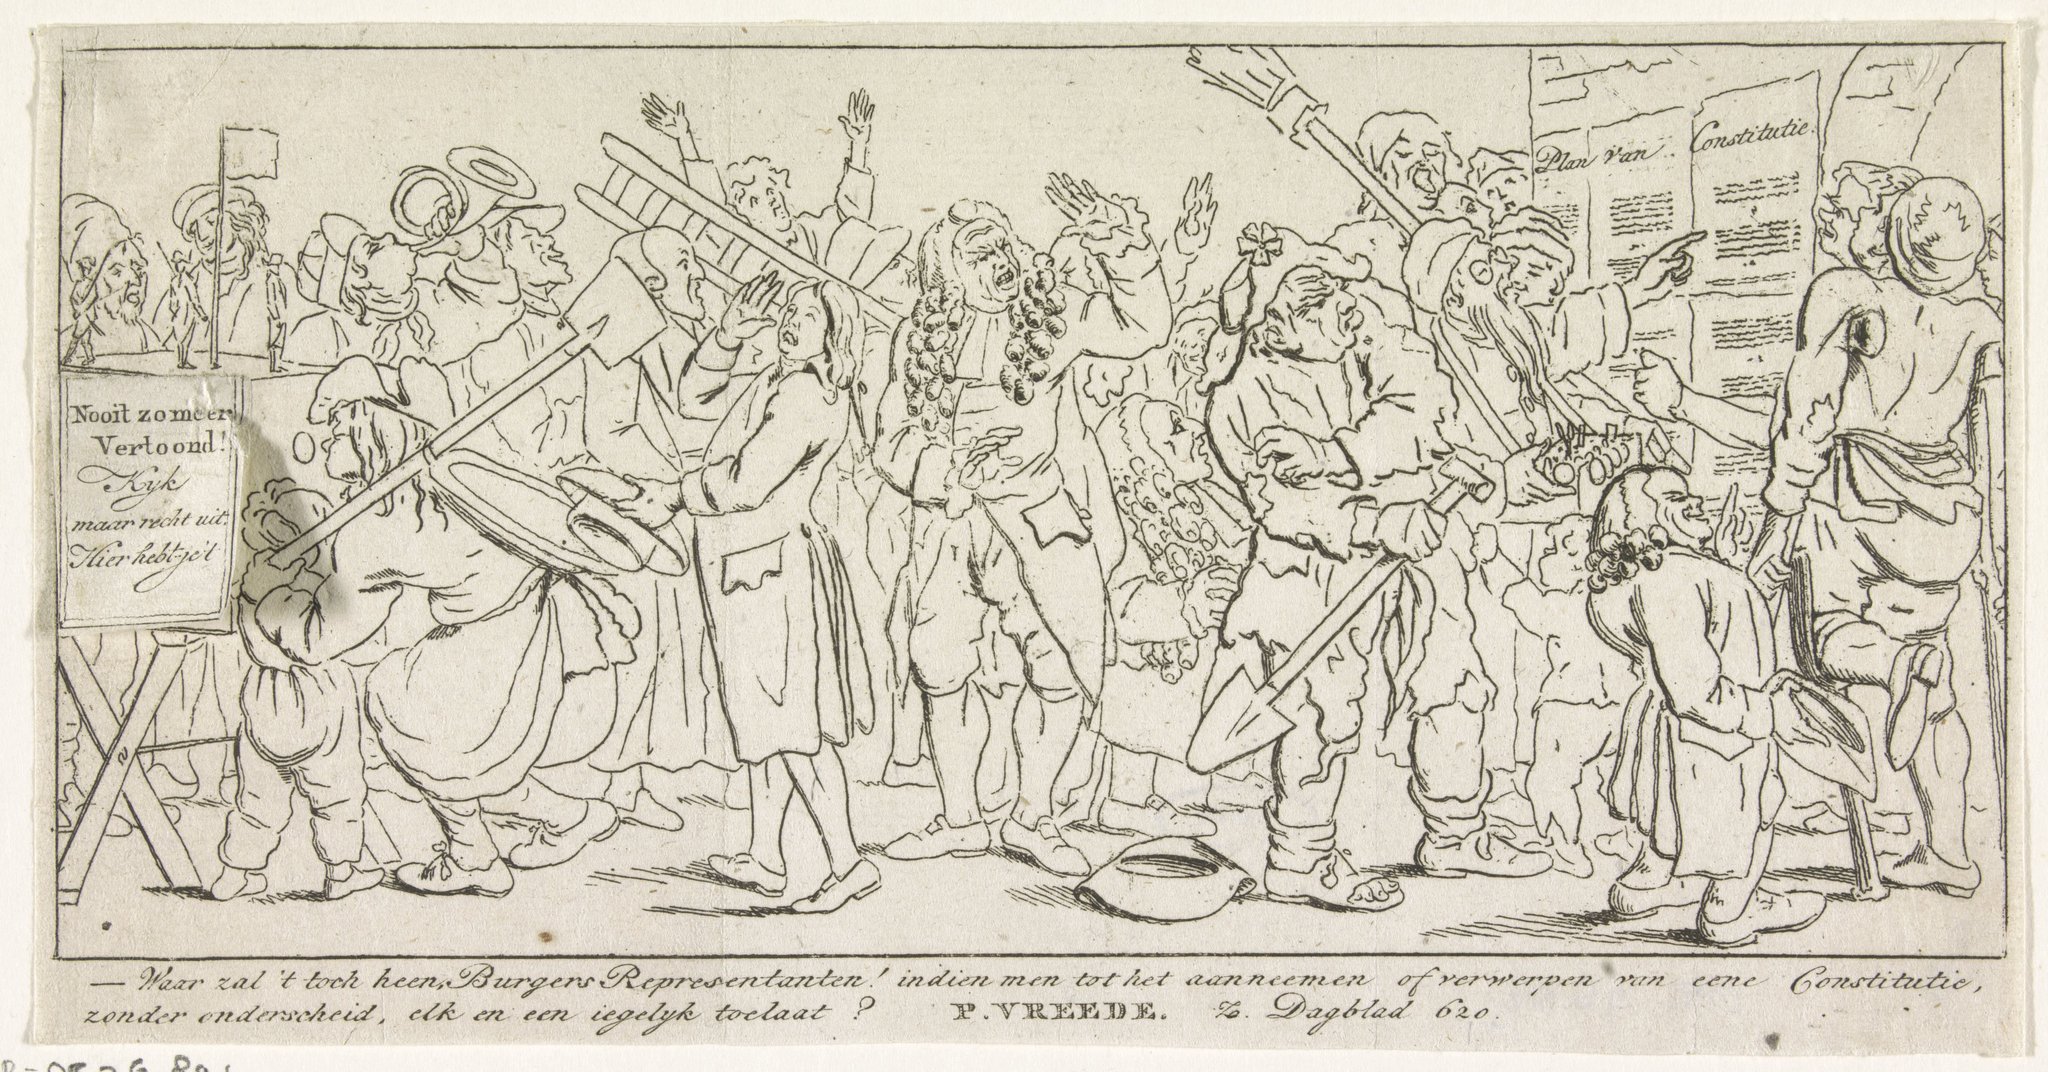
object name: print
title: Spotprent op verwerping van het Plan van Constitutie, 1797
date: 1797-1798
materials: paper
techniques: etching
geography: netherlands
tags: other kinds of amusement, political caricatures and satires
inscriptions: collector's mark: Lugt 2228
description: Spotprent waarin het volk het verwerpen van het Plan van Constitutie op 8 augustus 1797 bespot. Op een muur is het Plan geplakt dat gelezen en beoordeeld wordt het gewone volk en de burgerij. Links een kijkdoos waarbij een flap papier dat opgetild kan worden en waaronder te lezen staat: 189e Plan v. Constitutie, Anno 1961. Met tweeregelig onderschrift.